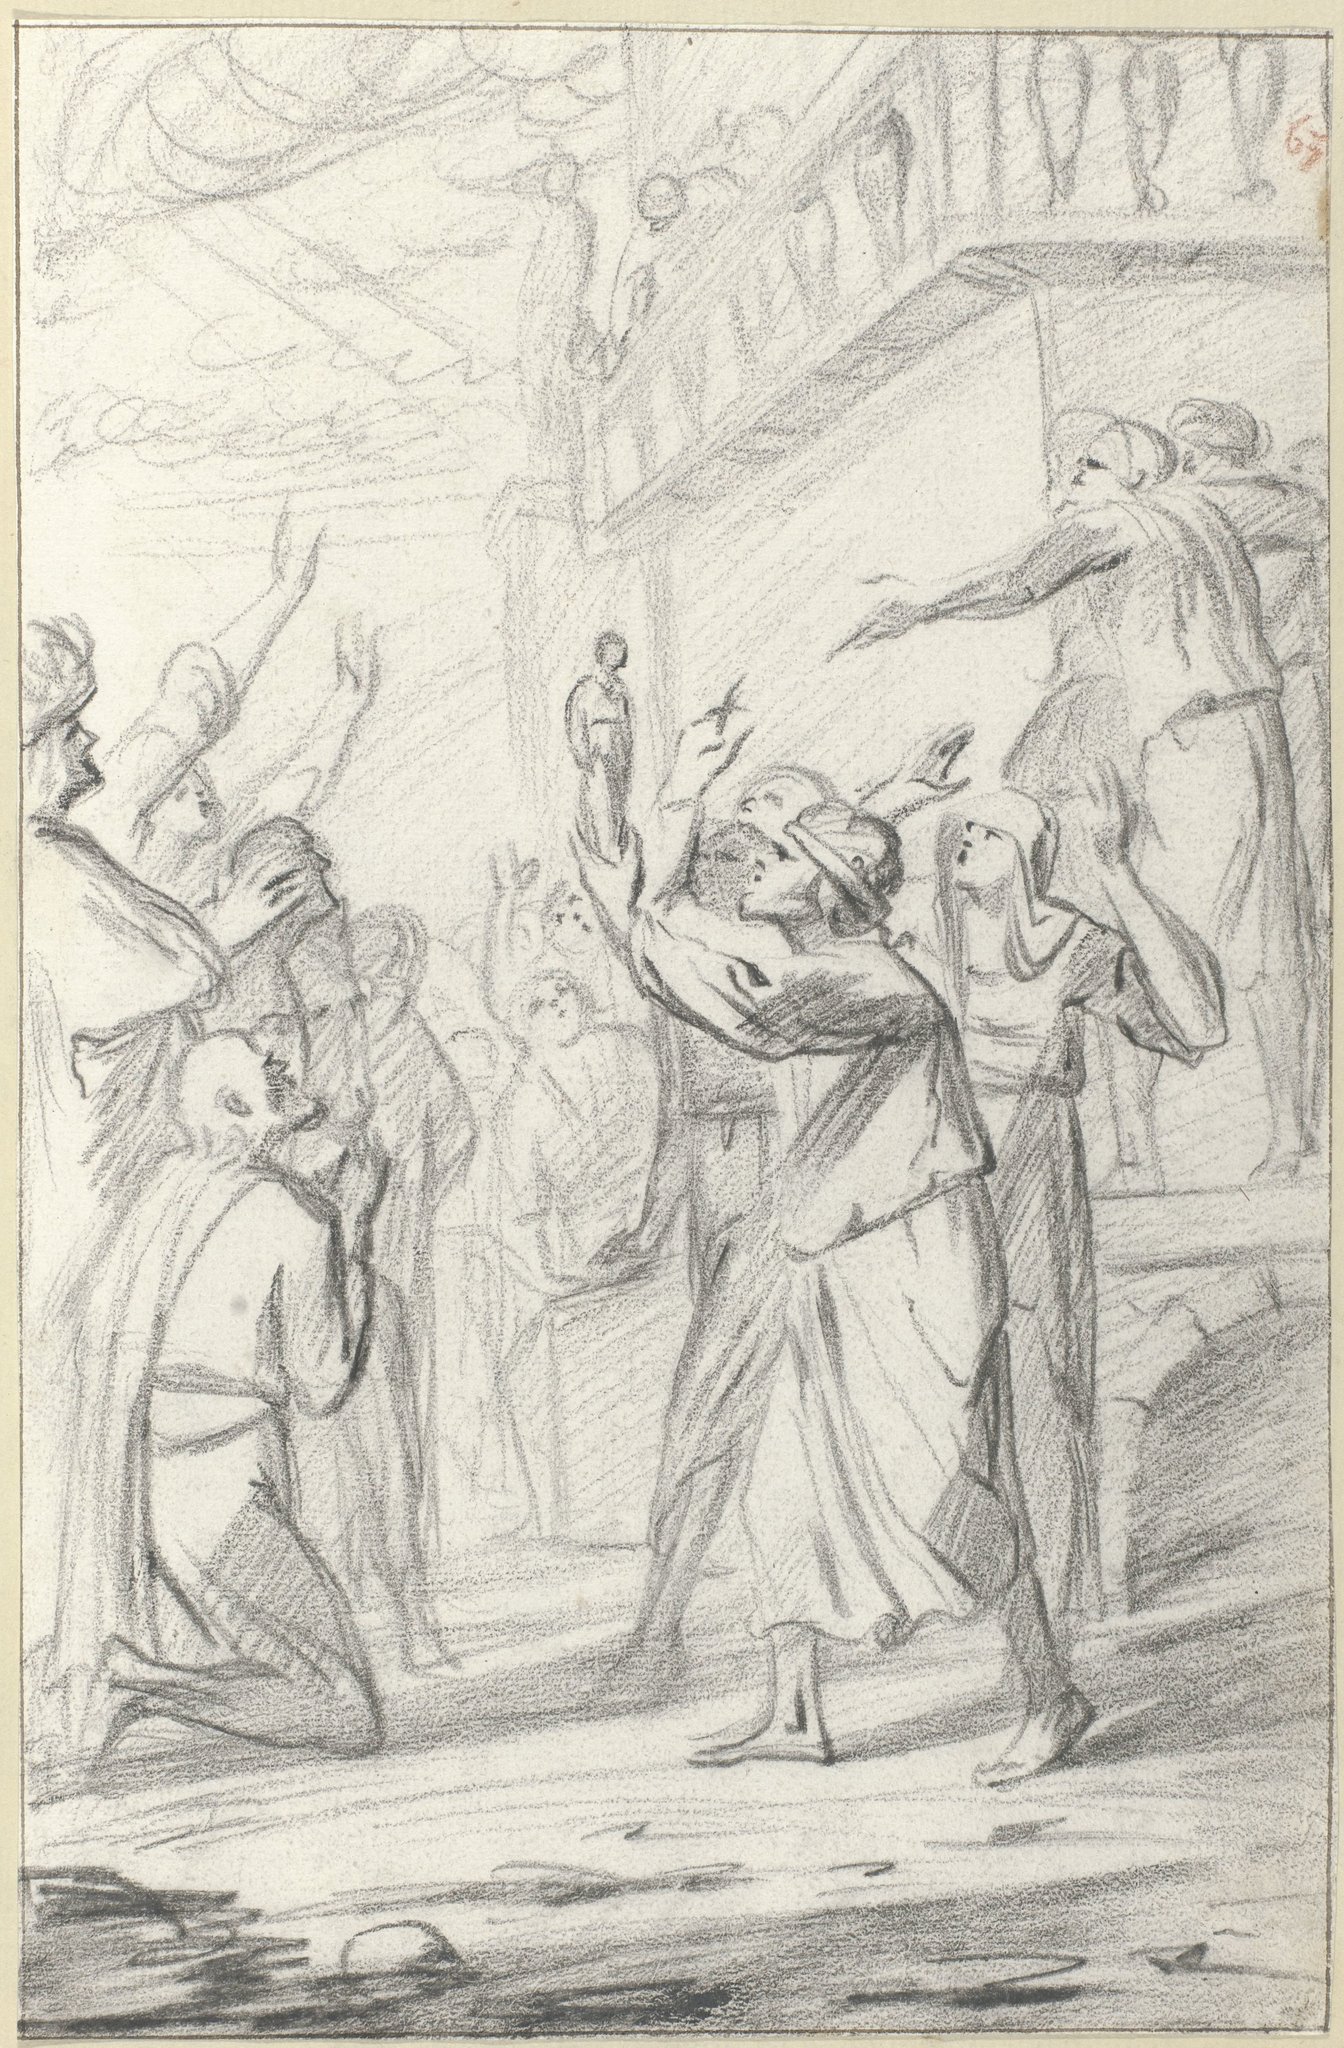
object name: drawing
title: Demetrius en de zilversmeden van Efese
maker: pieter fransz de grebber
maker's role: painter, print maker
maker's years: 1600-1653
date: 1610-1652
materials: chalk, paper